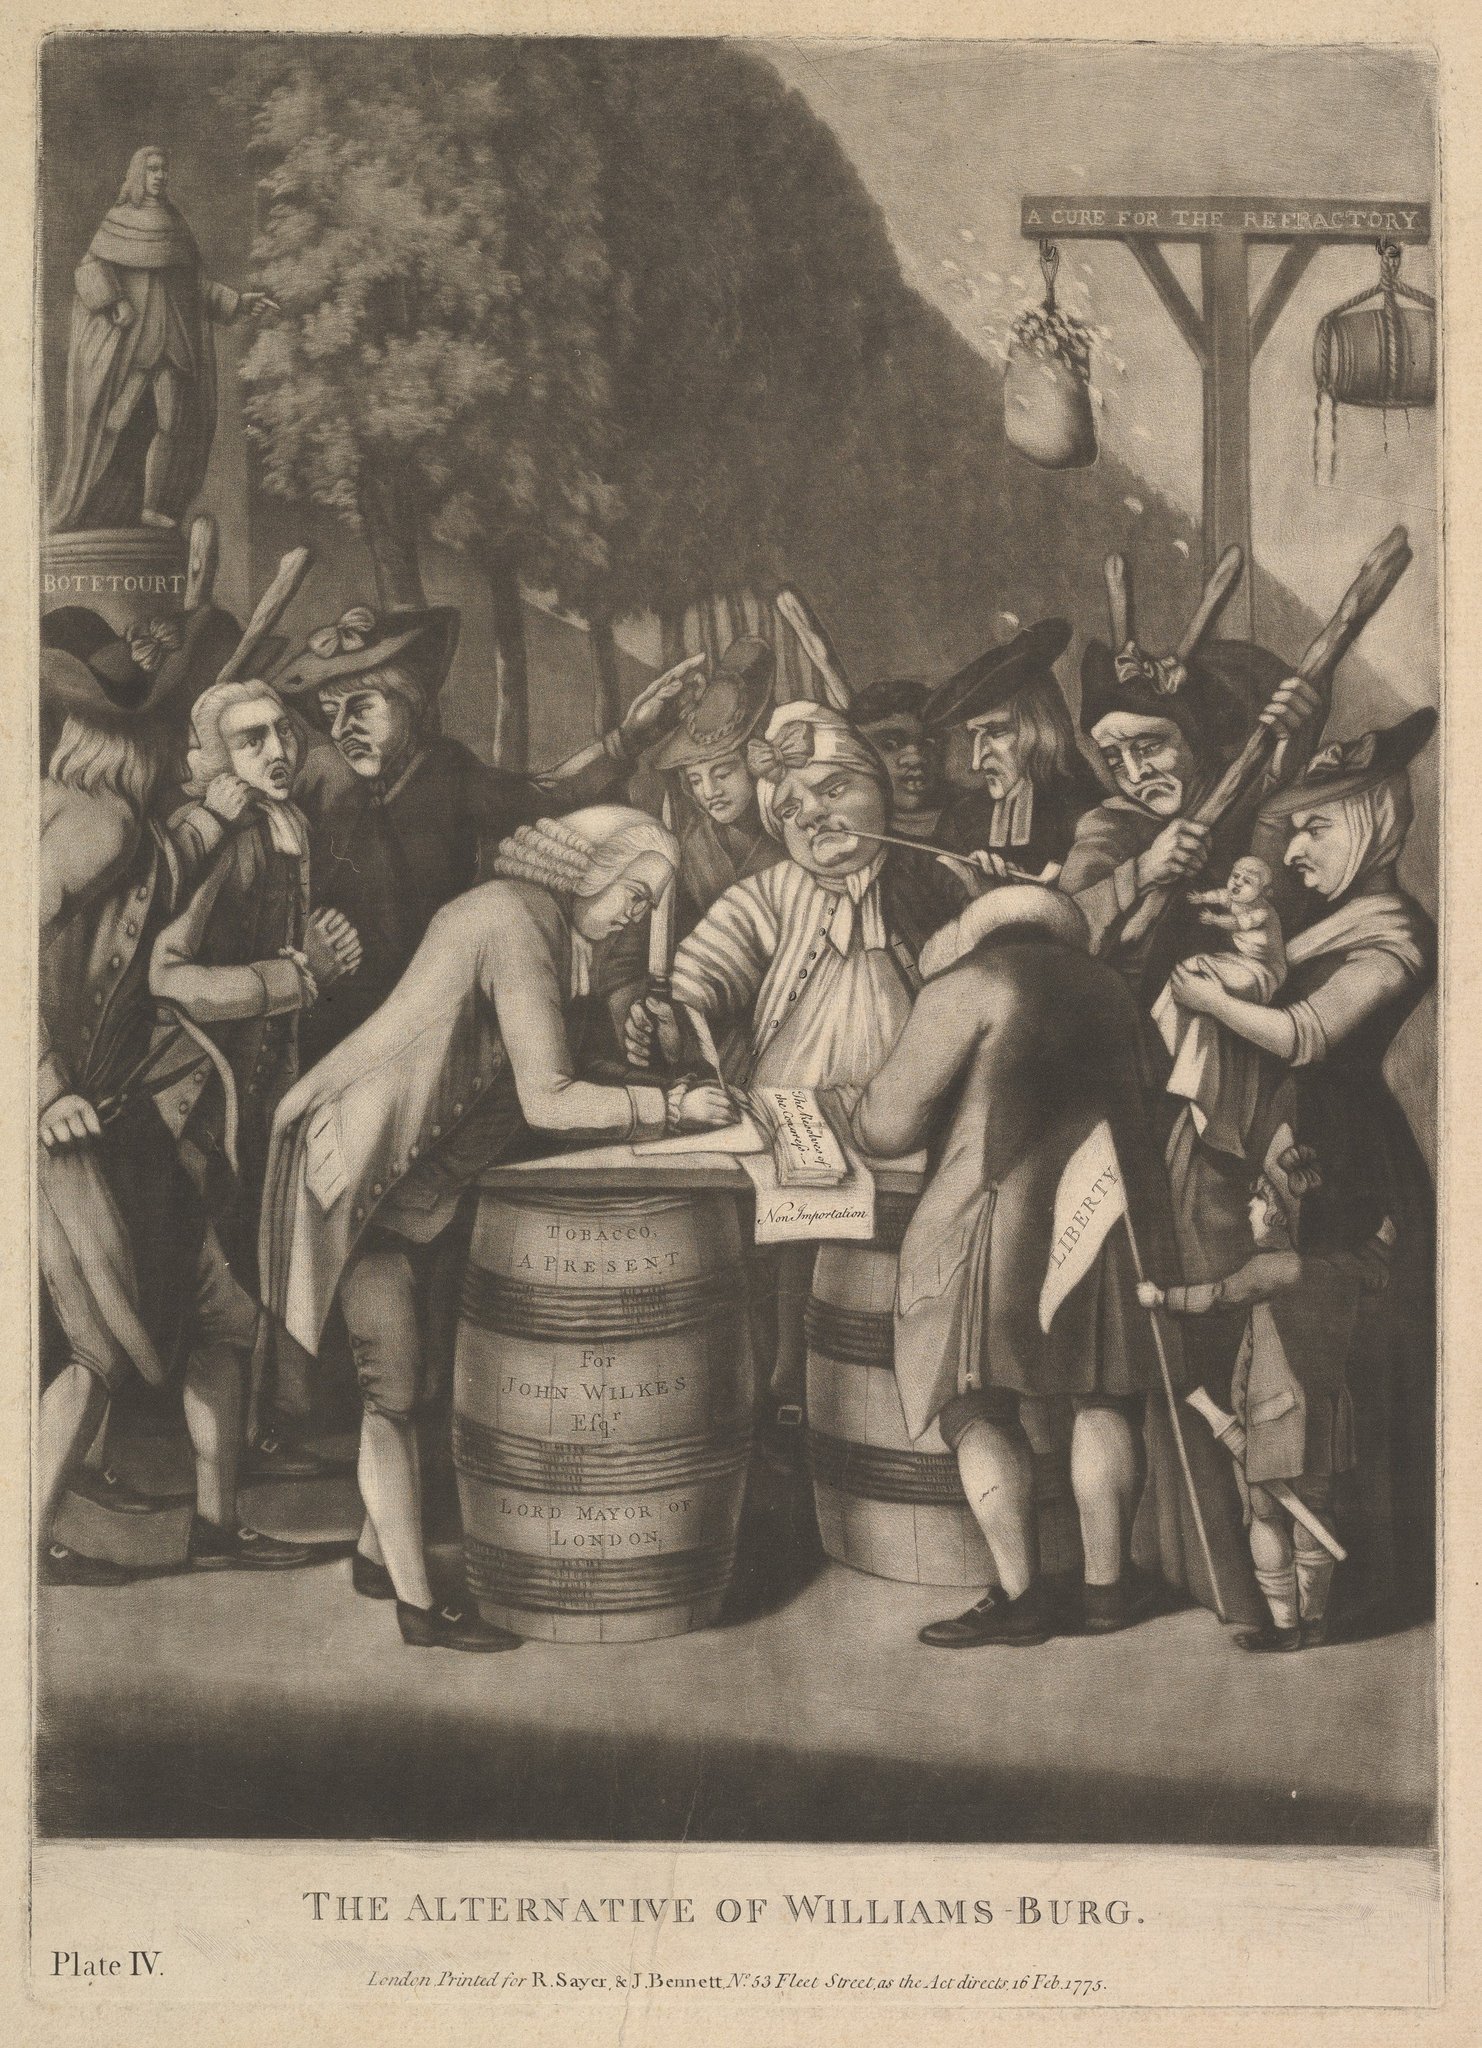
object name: print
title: The Alternative of WIlliams-Burg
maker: philip dawe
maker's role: artist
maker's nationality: british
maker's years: 1745-1809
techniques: mezzotint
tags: satire,american revolution,children,men,women,politics